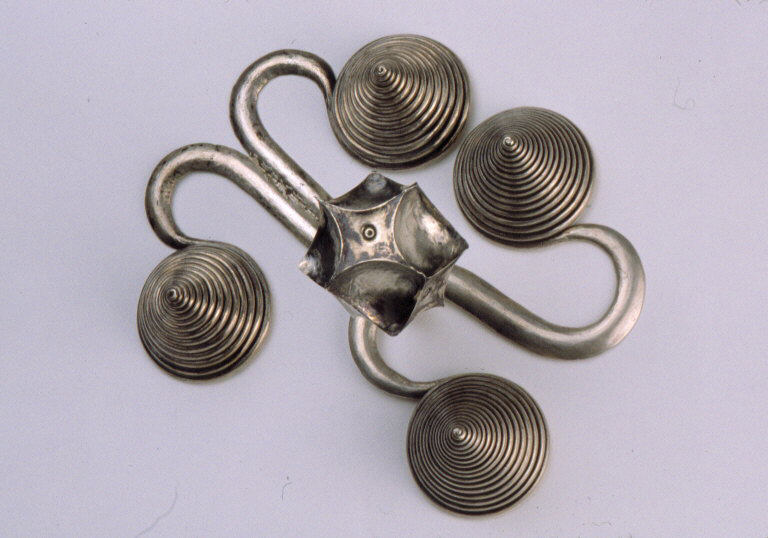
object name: ornament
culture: chinese, miao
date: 1867-1900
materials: silver